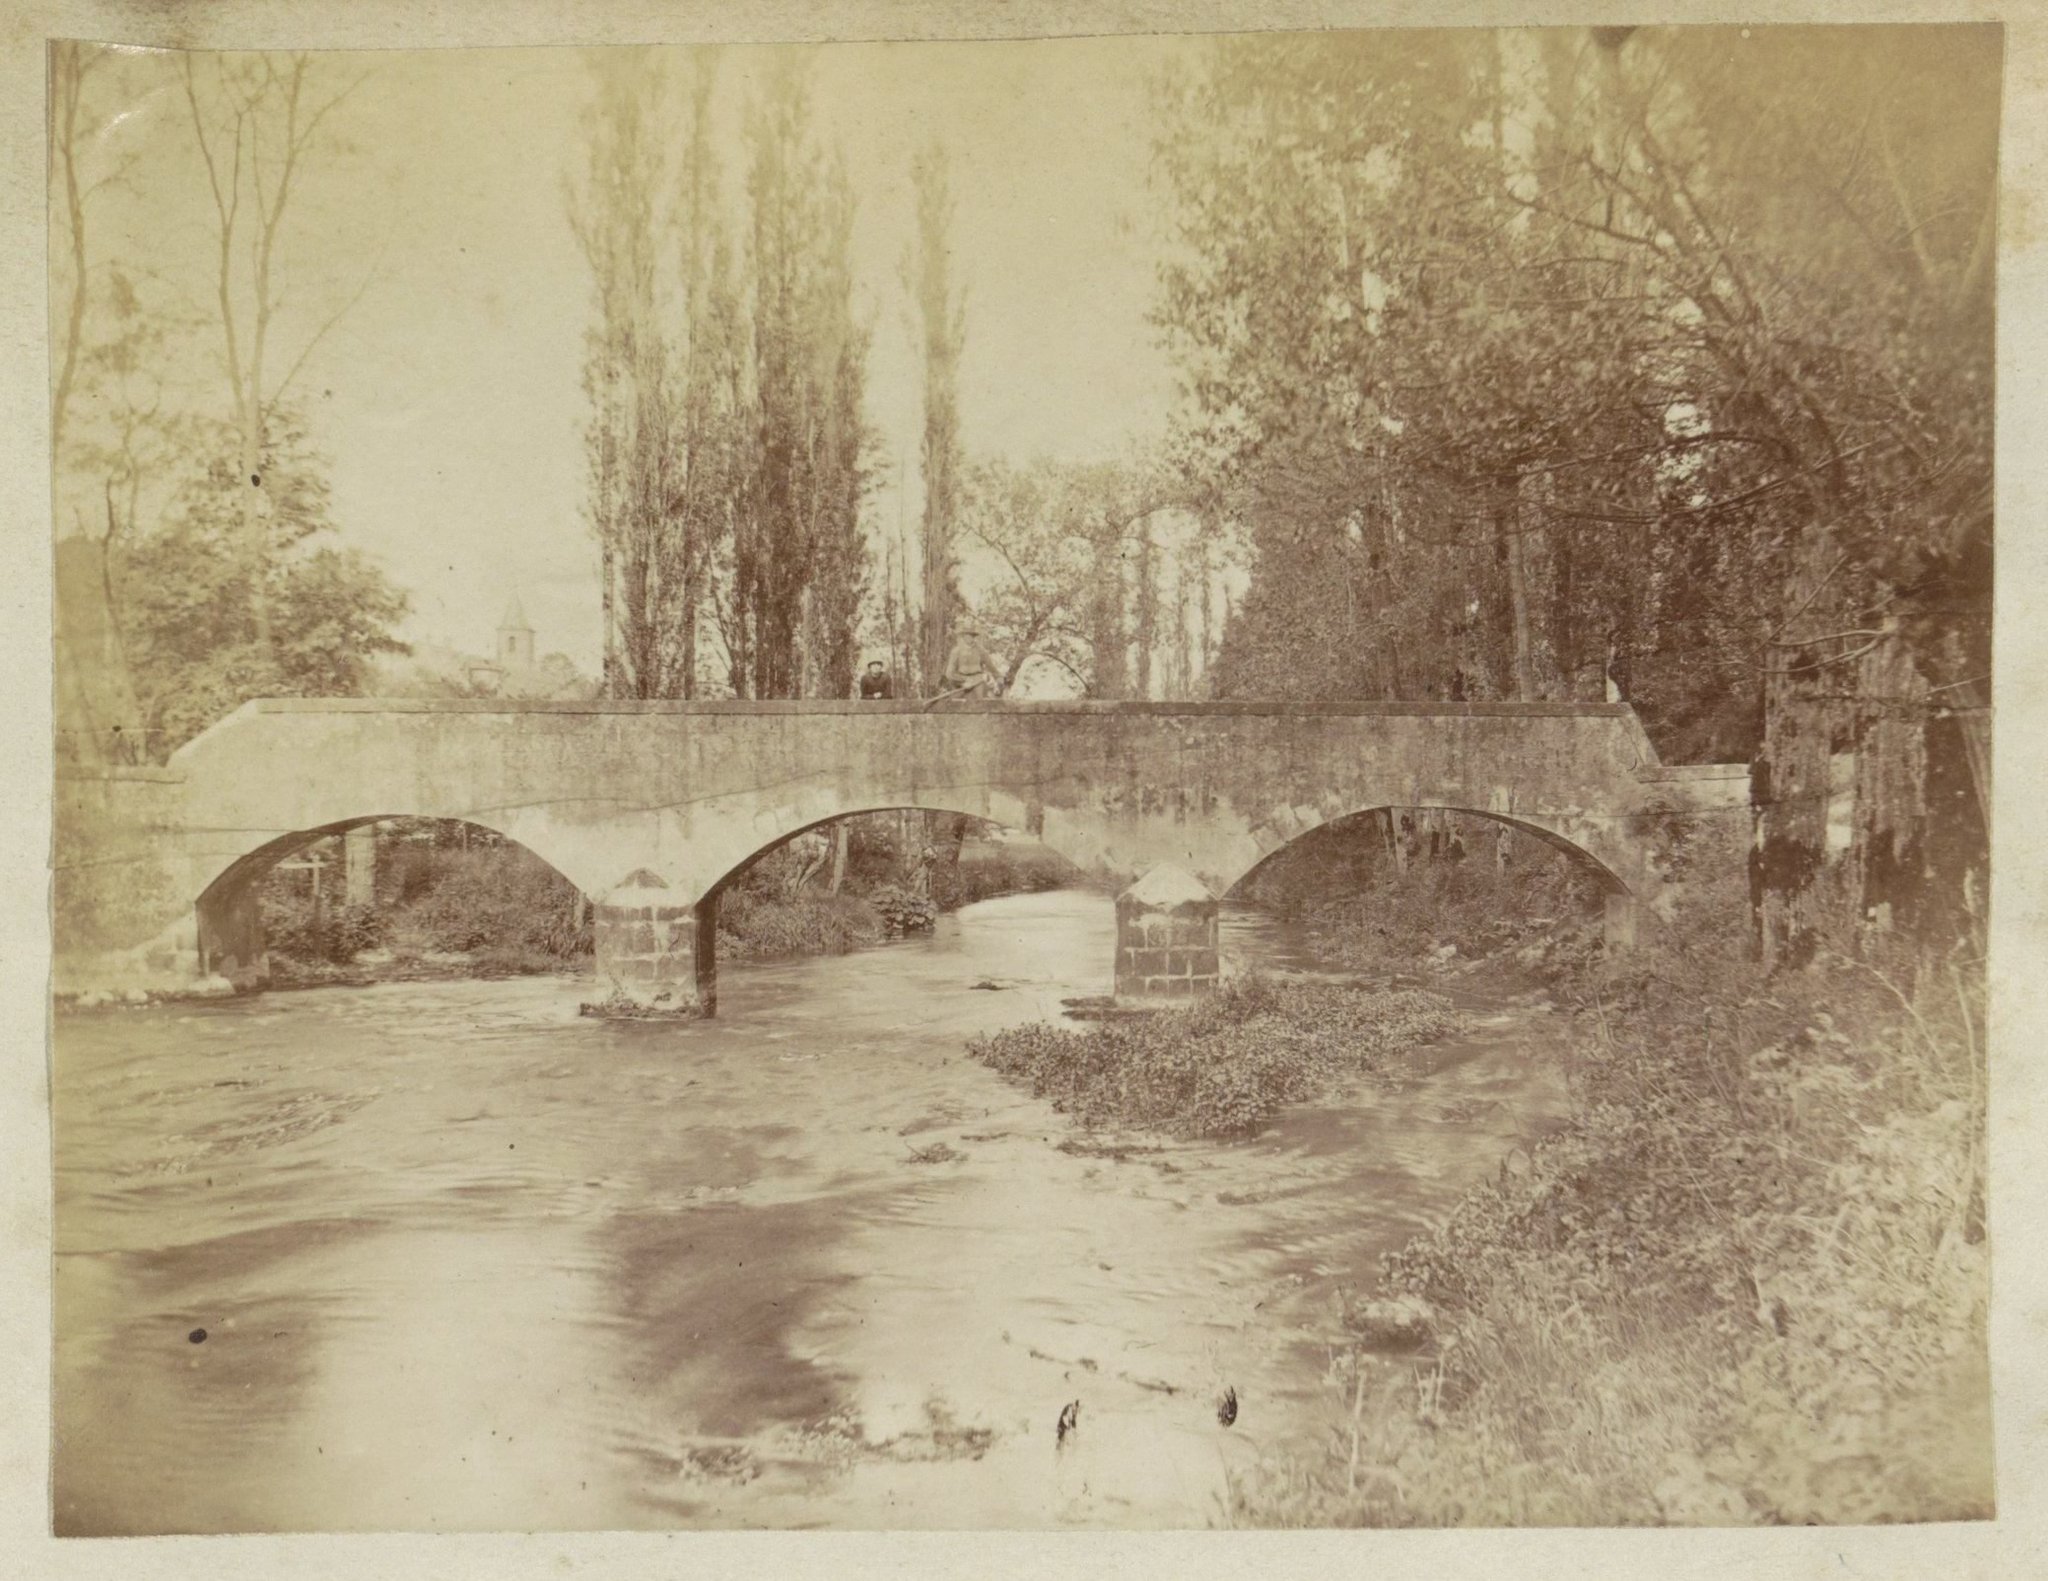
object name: photograph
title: Twee personen op een stenen brug over een beek in Frankrijk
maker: Anonymous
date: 1805-1884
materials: photographic support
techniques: albumen print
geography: france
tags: bridge in village across river, canal, etc., france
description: Onderdeel van Album van een Franse amateurfotograaf met opnames van familie, militairen, industrie, landschappen en bezienswaardigheden in Frankrijk.